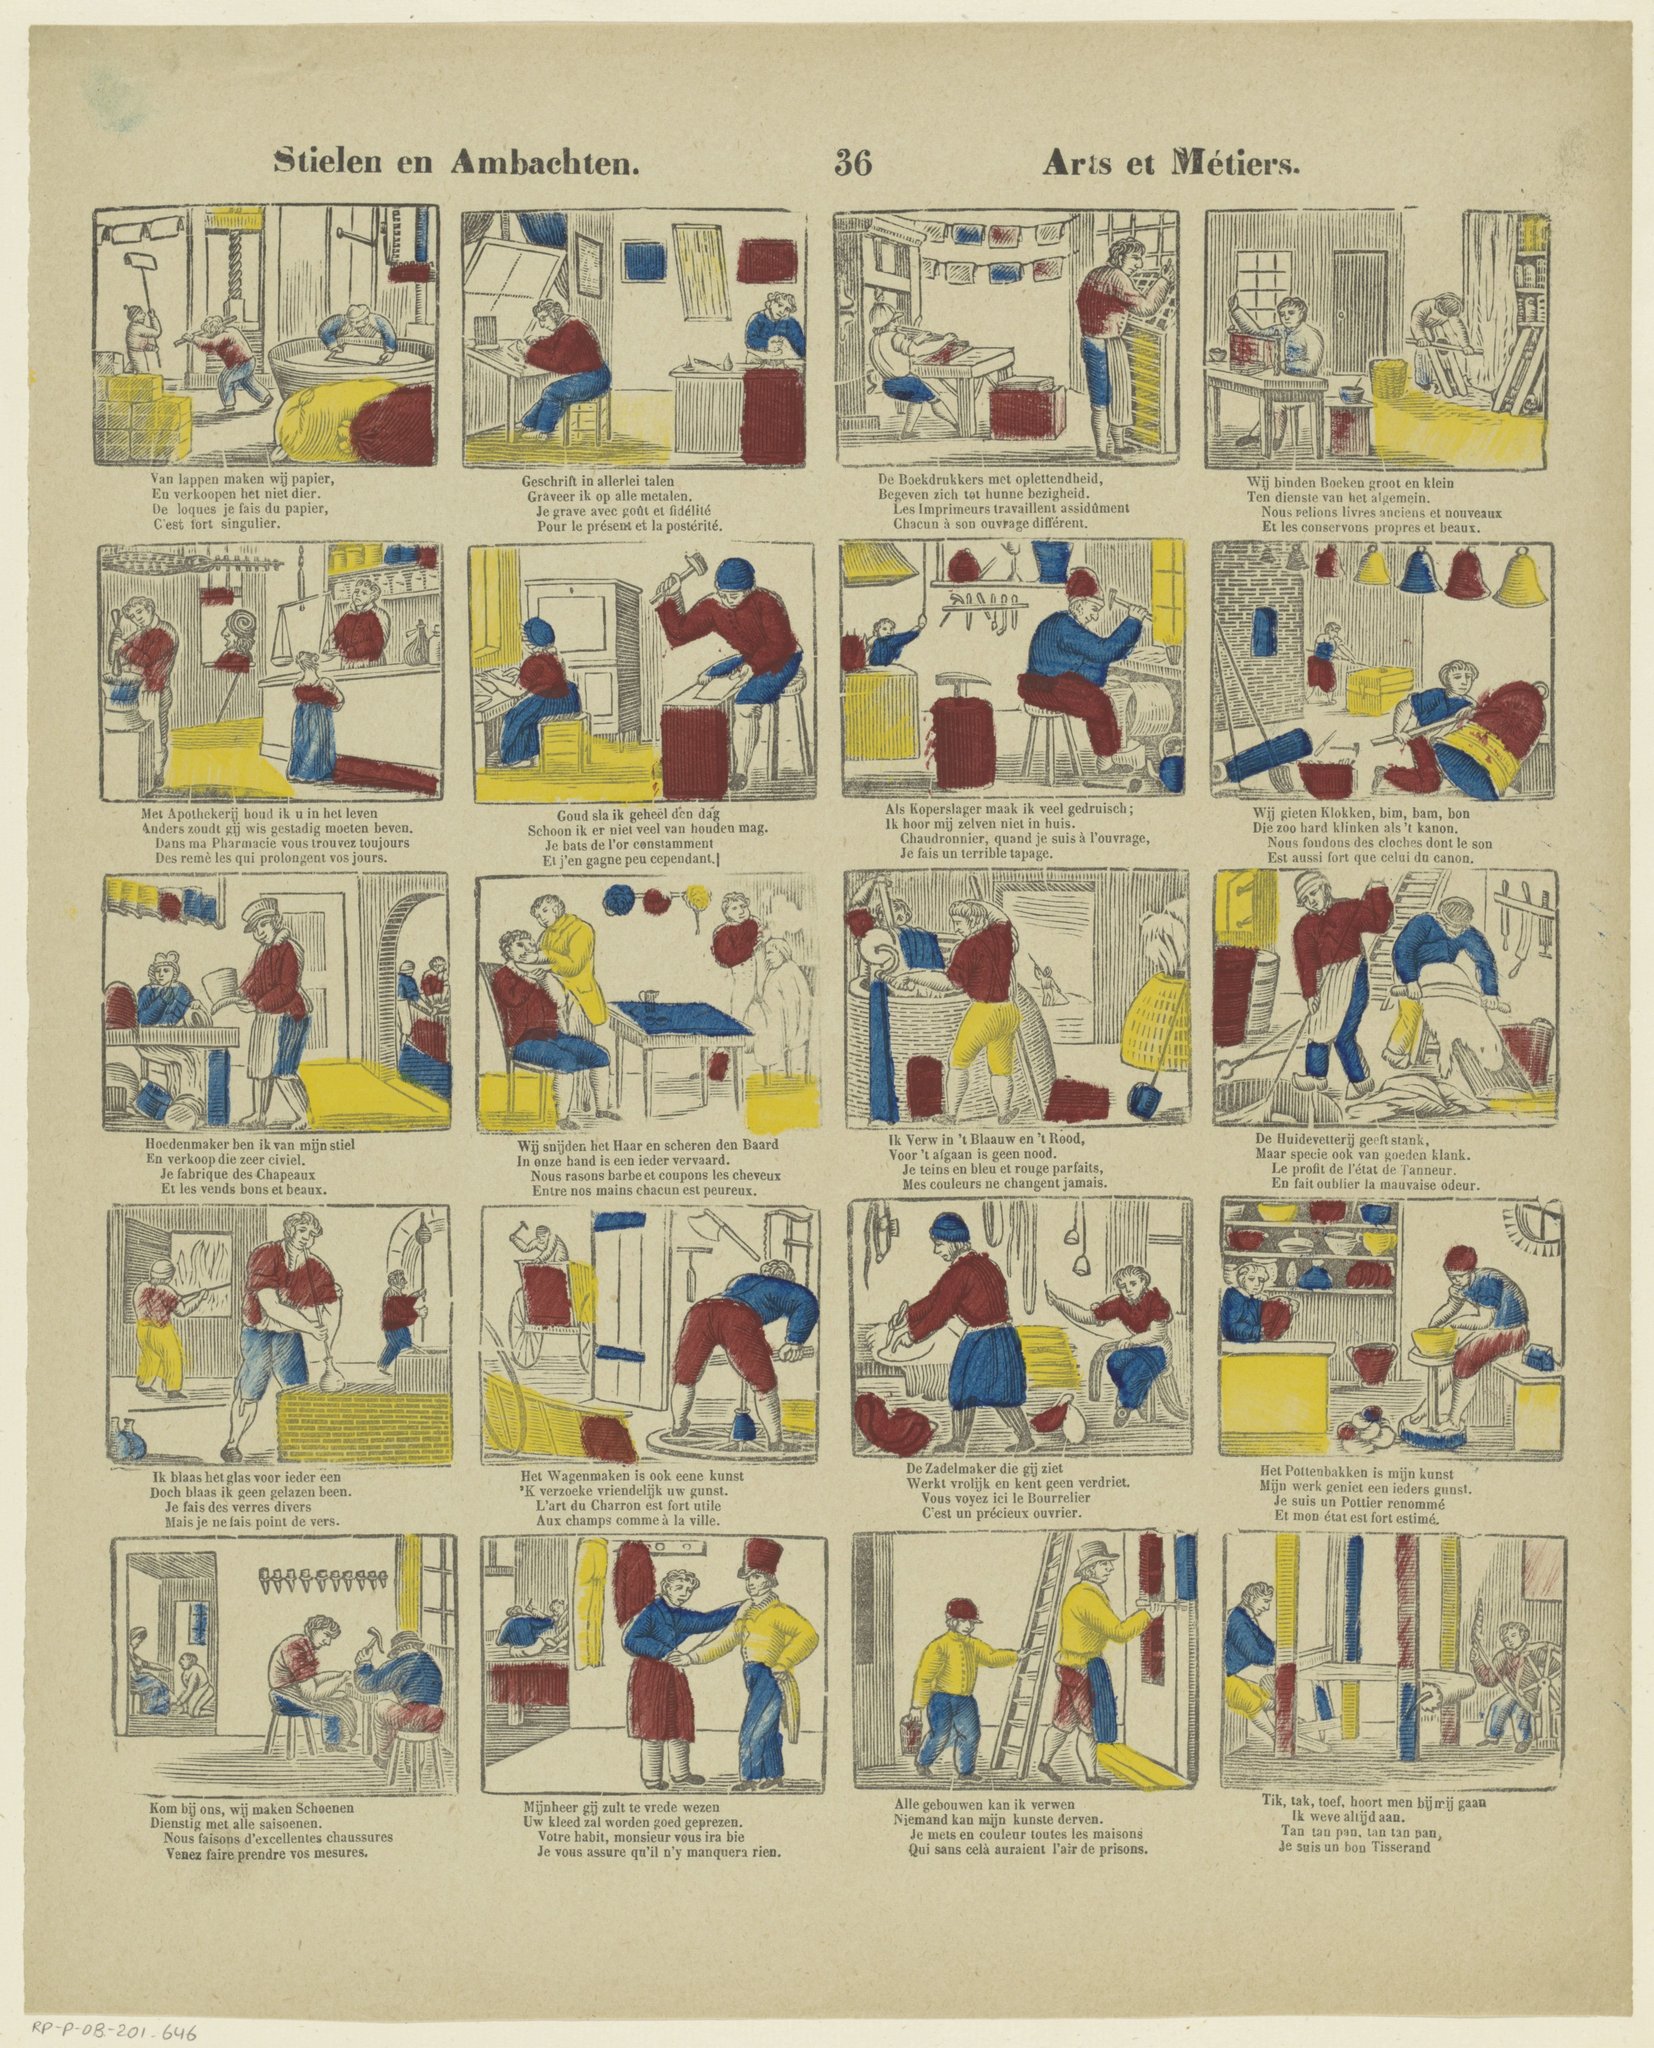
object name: popular print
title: Stielen en Ambachten / Arts et Métiers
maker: Anonymous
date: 1833-1911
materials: paper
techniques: colour, letterpress printing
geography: turnhout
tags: craft-production, skilled handiwork, pharmacist, druggist, apothecary; pharmacy, drugstore, dispensing chemist, painter at work, in his studio - cc - out of doors, crafts and industries, potter, ceramist, shoe-maker, cobbler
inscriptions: collector's mark: Lugt 2760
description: Blad met 20 voorstellingen van ambachtslieden en beroepen, zoals papiermaker, koperslager, barbier en schilder. Onder elke afbeelding een tweeregelig vers in het Nederlands of in het Frans. Genummerd midden boven: 36.